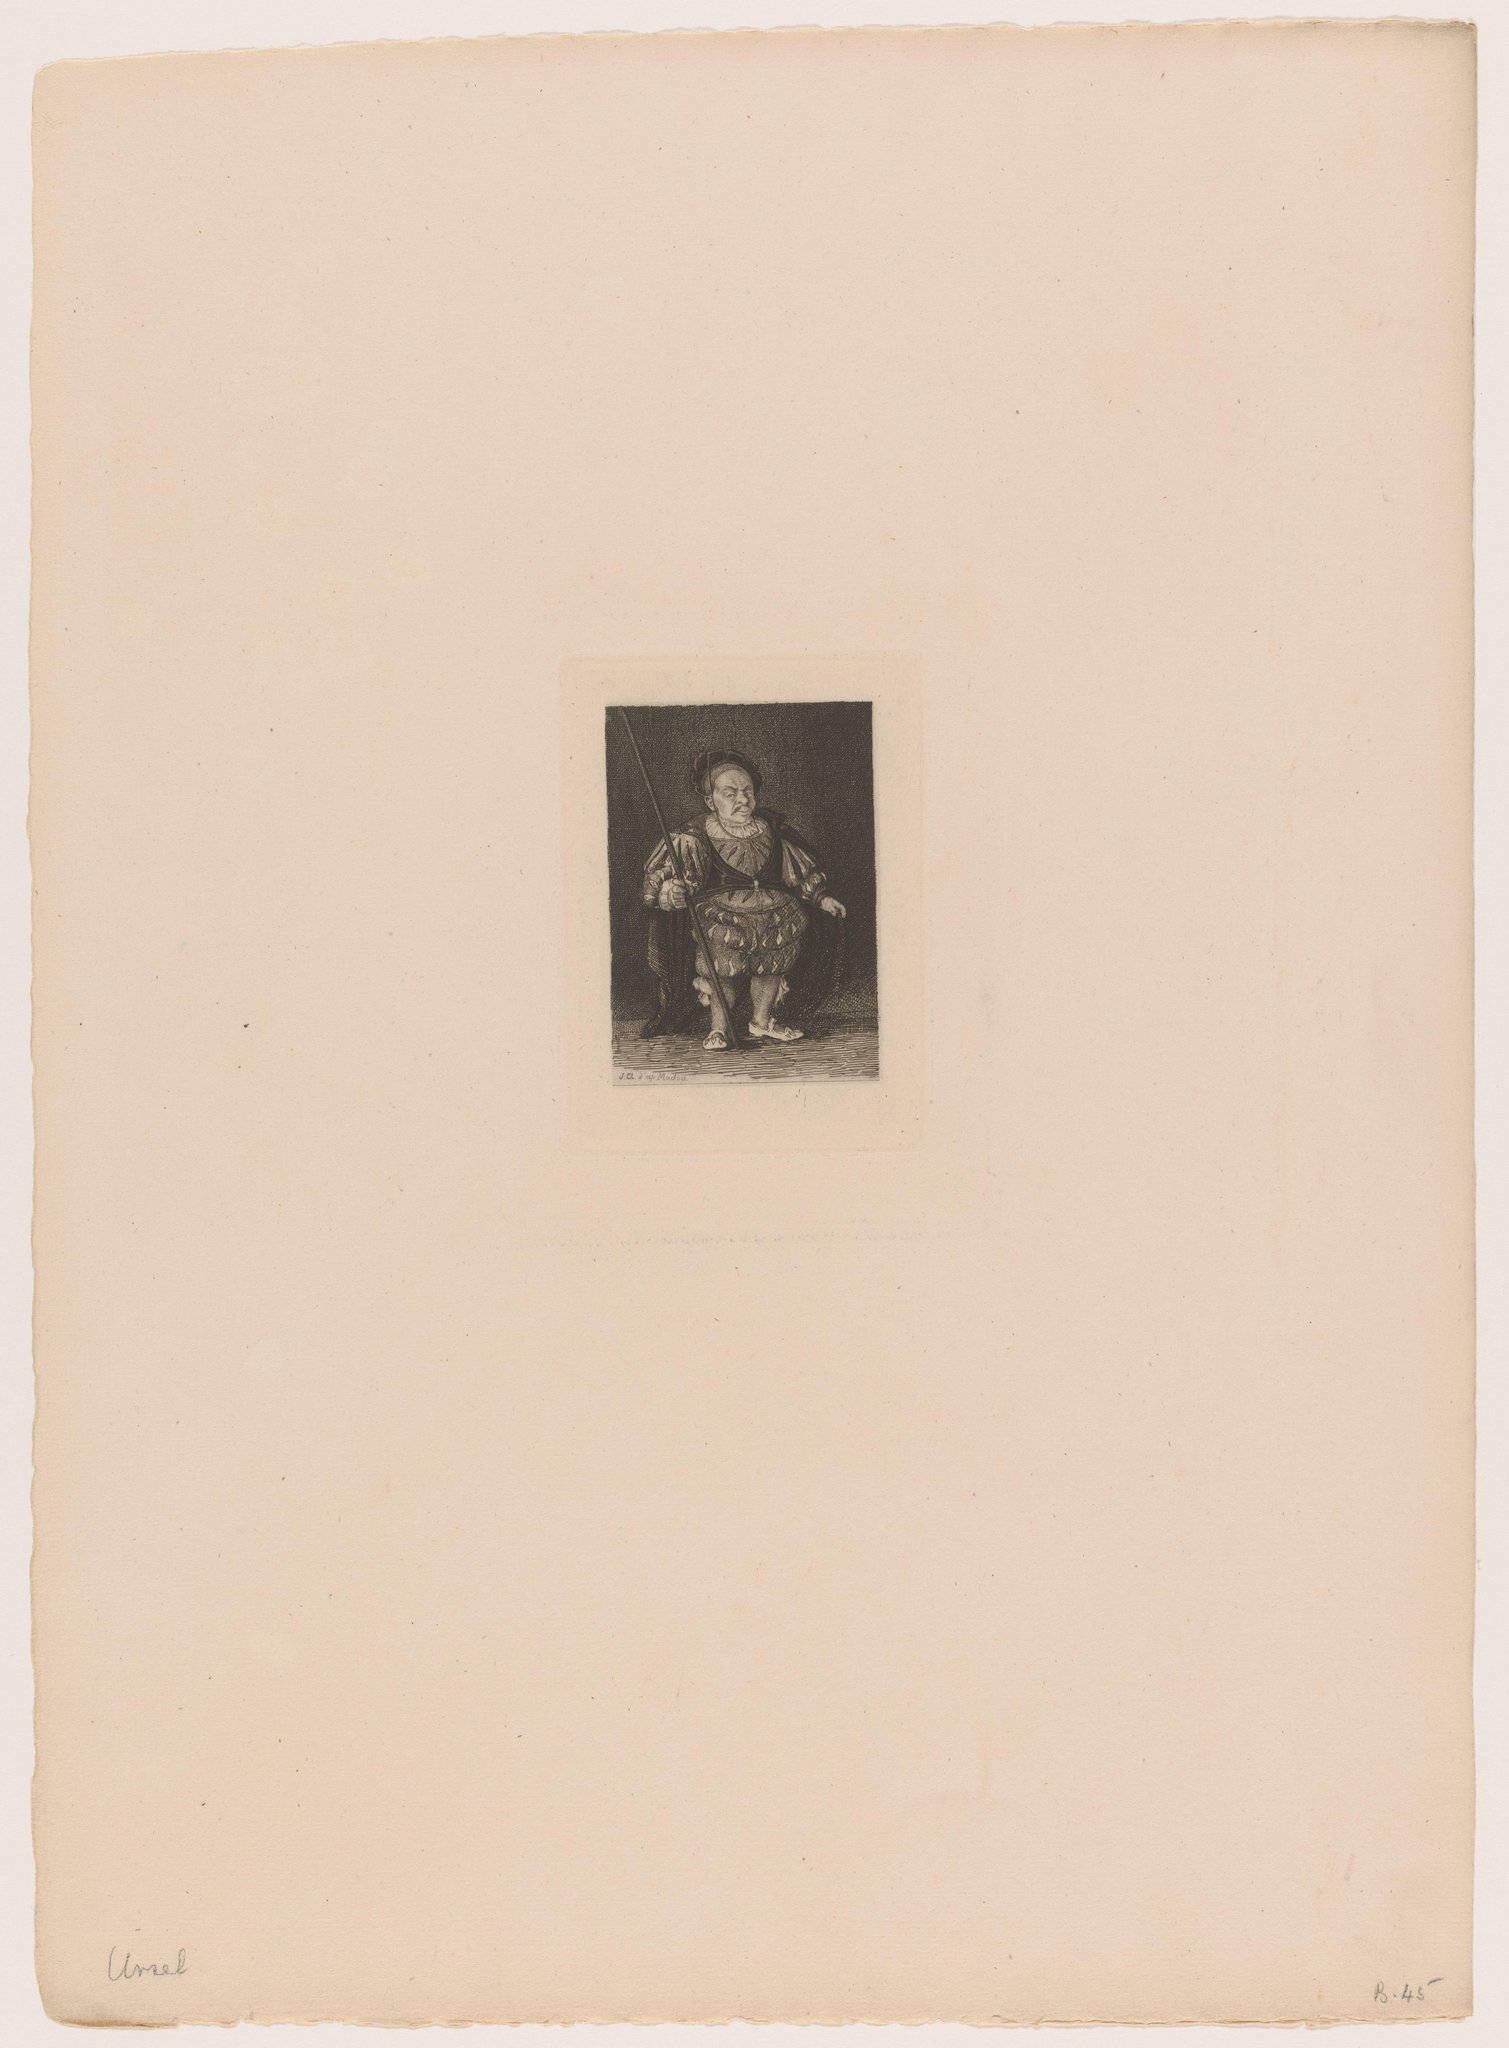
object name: print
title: Nar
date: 1875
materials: paper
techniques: drypoint, etching, intaglio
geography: brussels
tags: court jester, court fool, buffoon (in general) (german: 'schalksnarr'), little people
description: Prent uit: Rops, Félicien (red.), Cahier d'études eaux-fortes originales et inédites. Brussel: Felix Callewaert père, 1875.